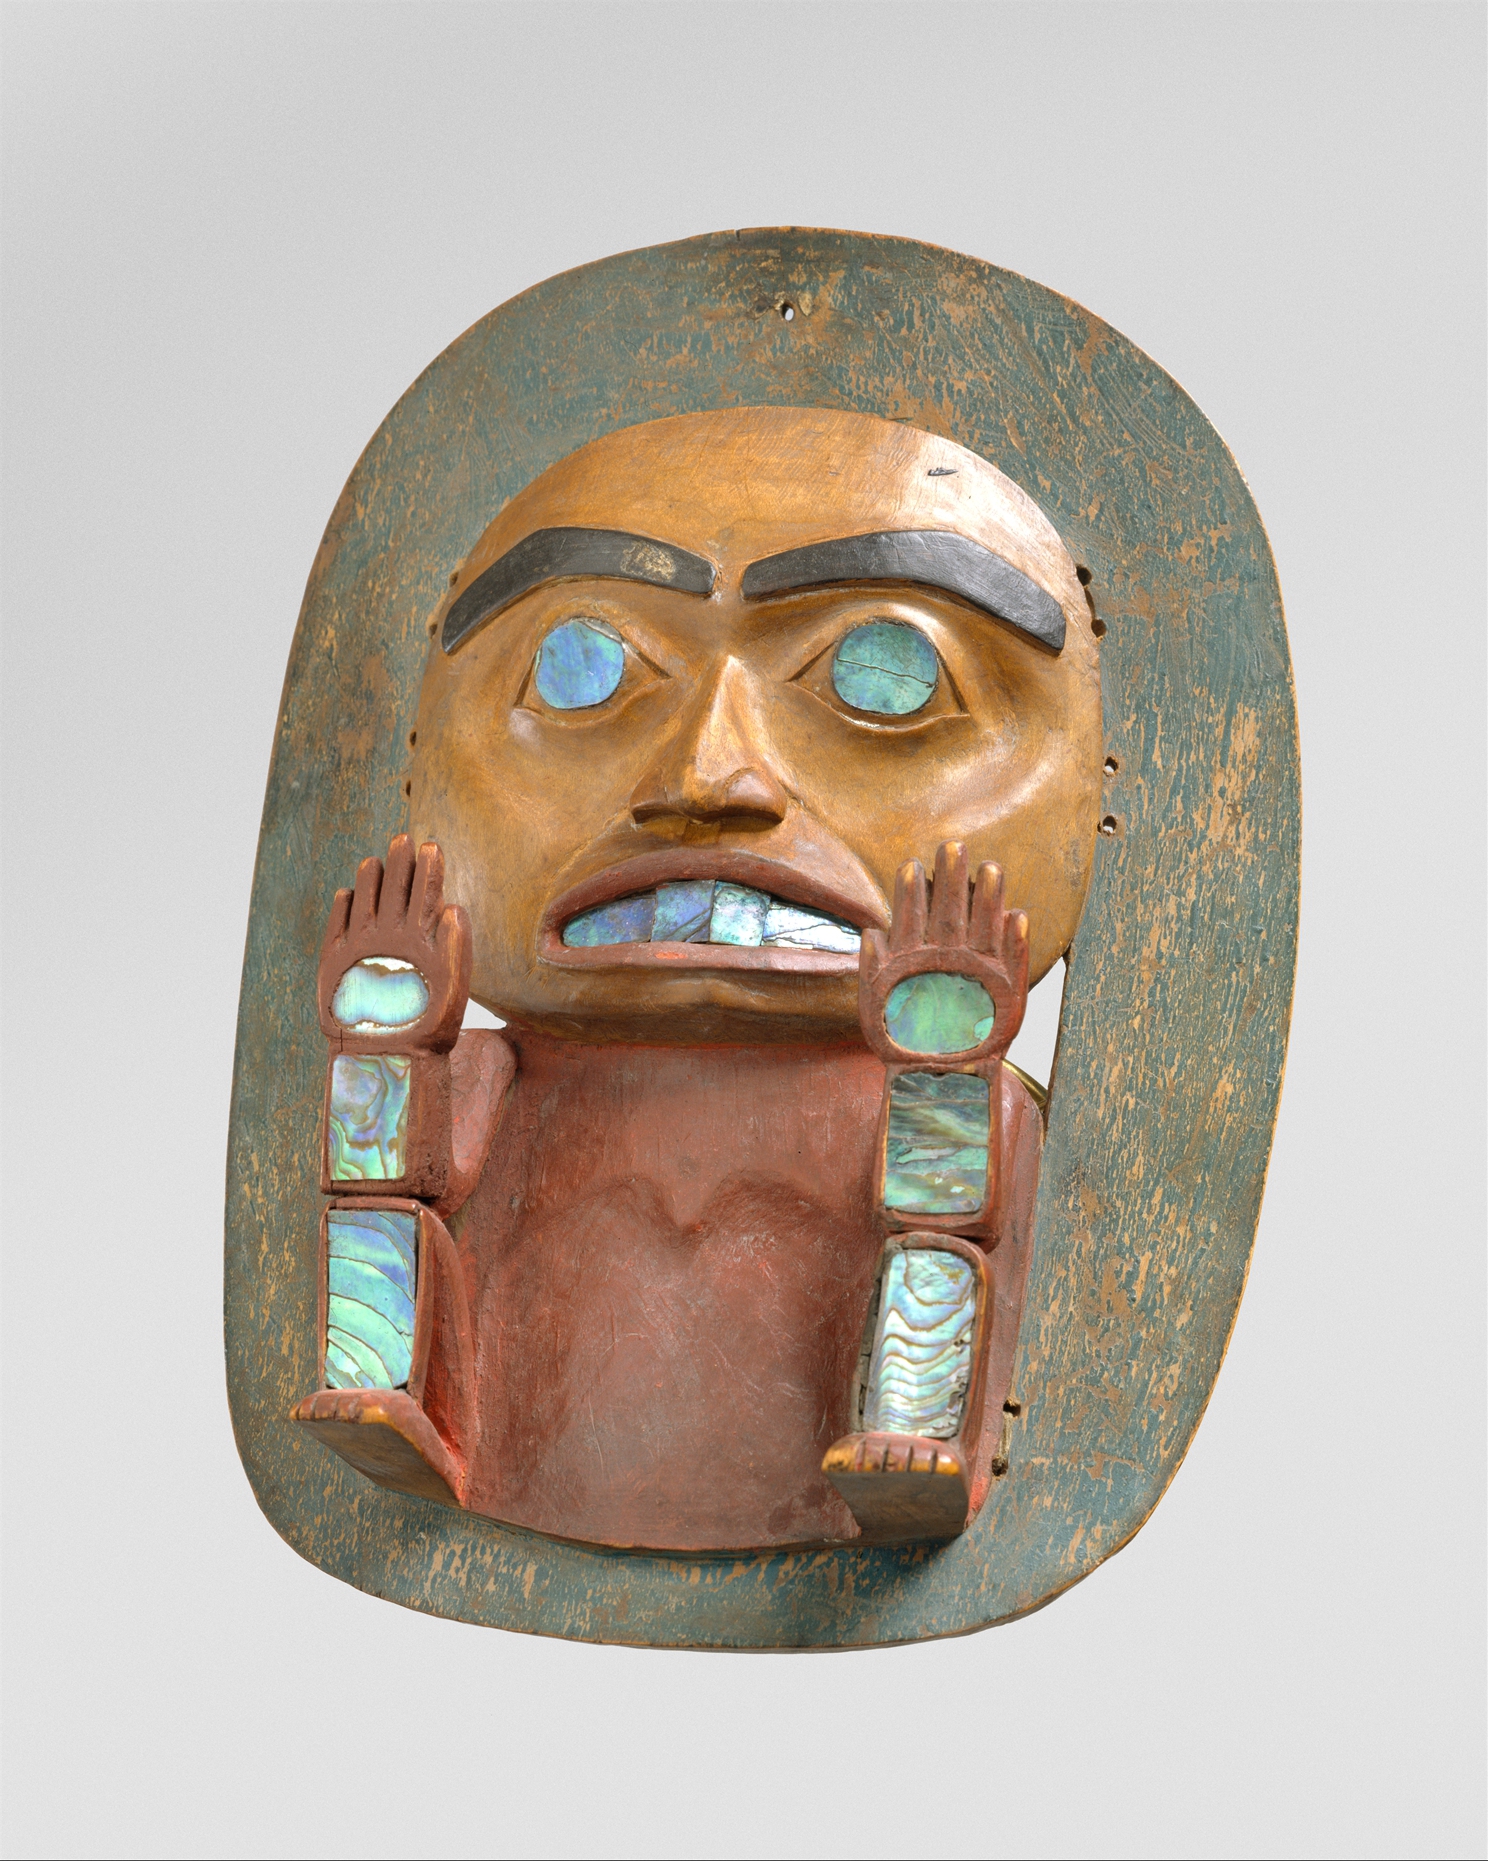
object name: frontlet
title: Headdress Frontlet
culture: tsimshian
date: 1820-1840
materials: pigment, shell, wood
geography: canada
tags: faces